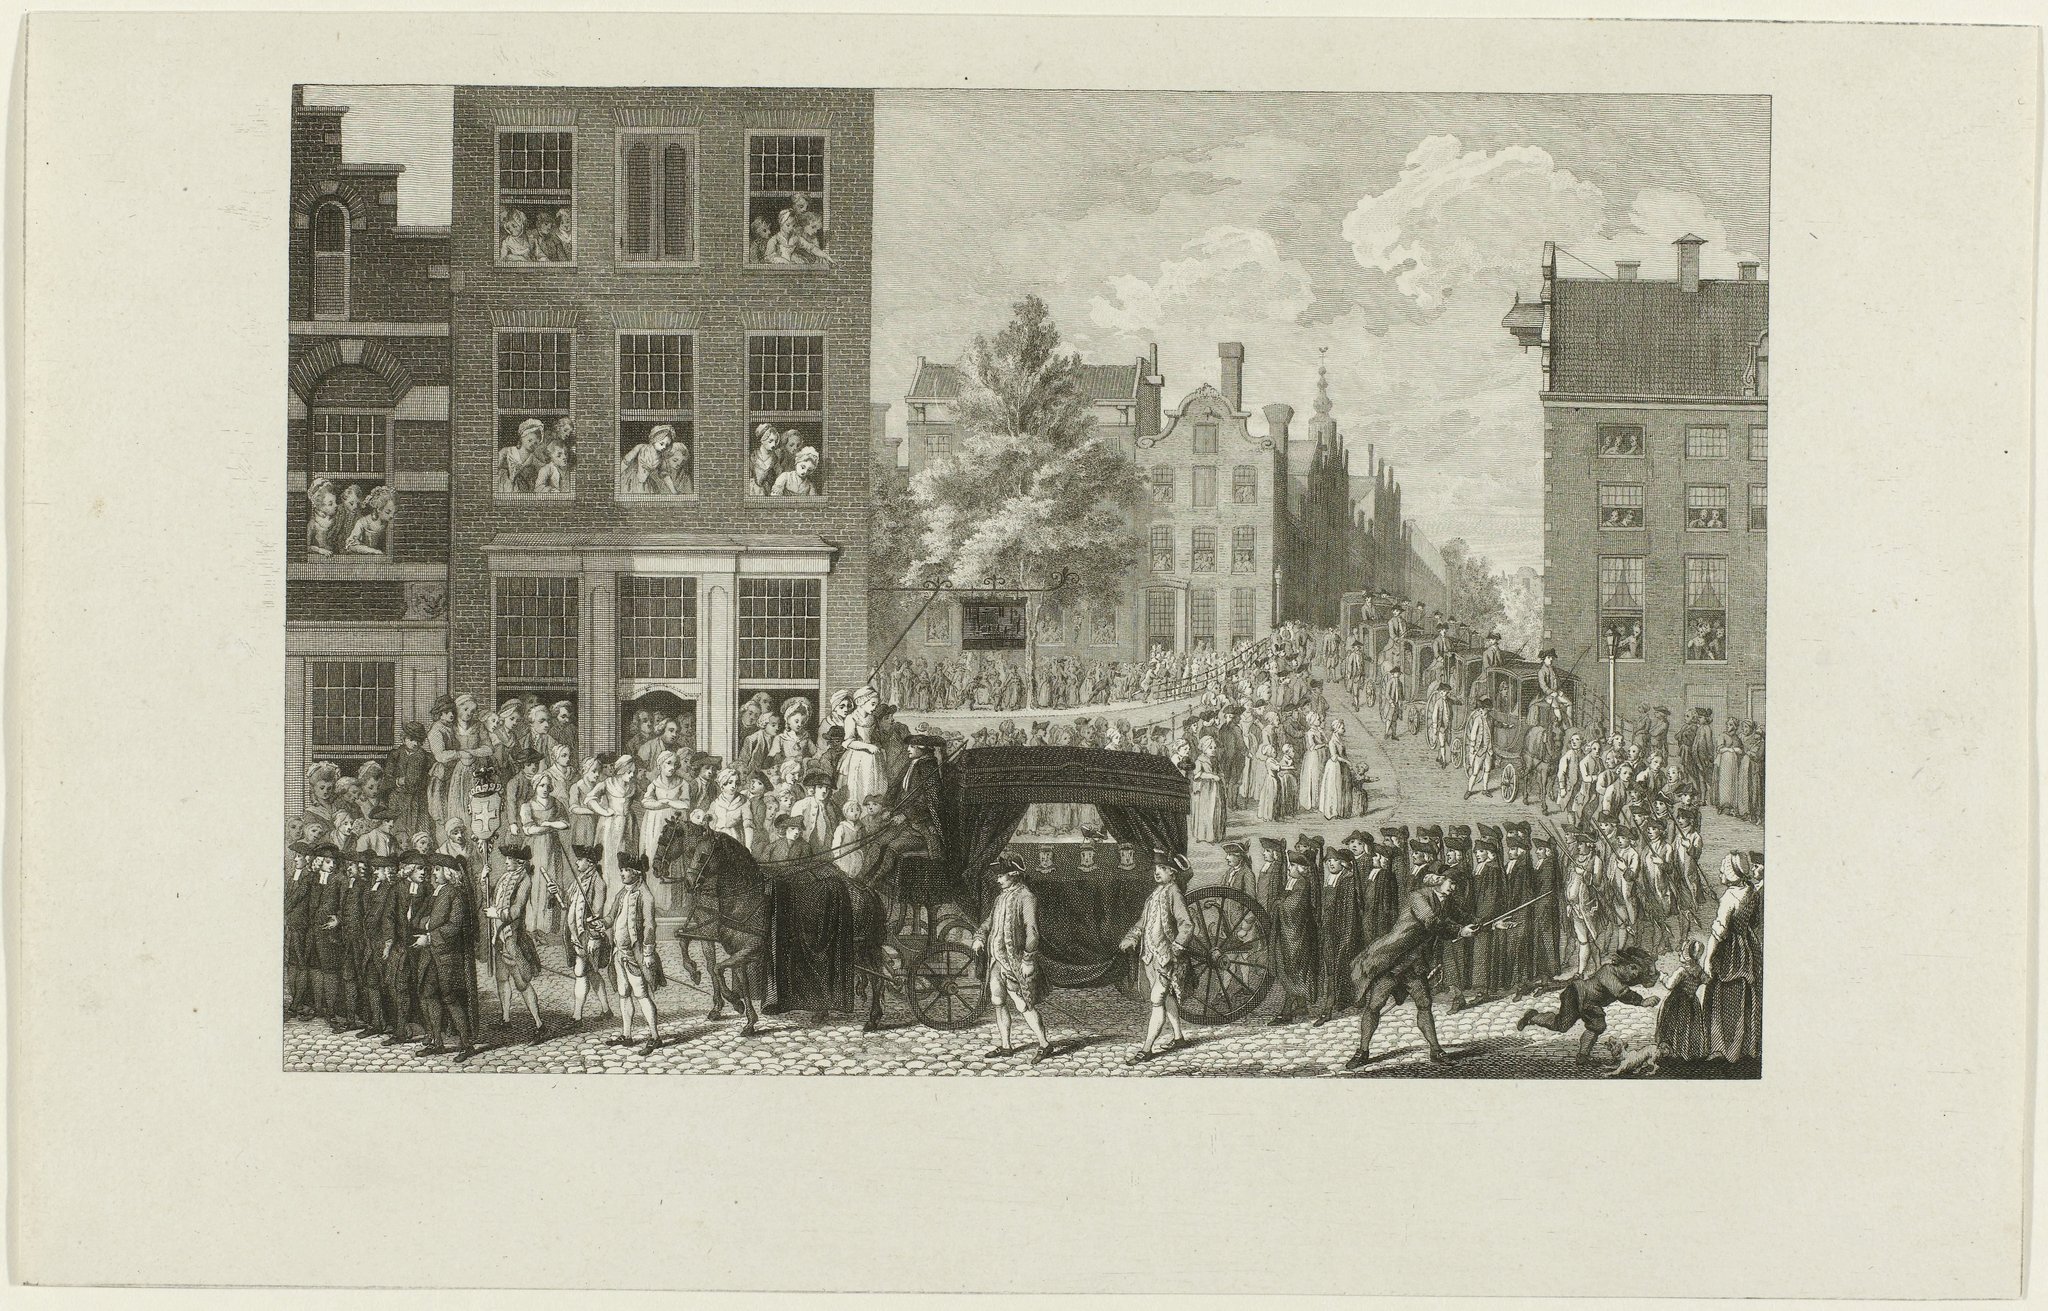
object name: print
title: Lijkstatie van Wolter Jan Gerrit baron Bentinck, 1781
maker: harmanus vinkeles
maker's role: draughtsman, print maker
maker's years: 1745-1825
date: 1782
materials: paper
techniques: engraving, etching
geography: amsterdam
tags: funeral carriages, cortege, funeral procession, public funeral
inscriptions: collector's mark: Lugt 2228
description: Latere (derde) staat van deze prent was bestemd voor gebruik als illustratie in: Francq van Berkhey, Johannes le. De zeetriumph der Bataafsche vryheid, op Doggersbank. Bevochten den 5den van Oogstmaand 1781. 2 delen. Amsterdam: Johannes Allart, 1782. De prent was echter niet op tijd klaar om in het boek opgenomen te worden, maar werd alsnog later door de uitgever aan de intekenaren geleverd. Voor tweede bekende staat zie RP-P-OB-66.099 en RP-P-1878-A-1766. Voor derde bekende staat zie RP-P-AO-28-110. Voor vierde bekende staat zie RP-P-1944-1923.